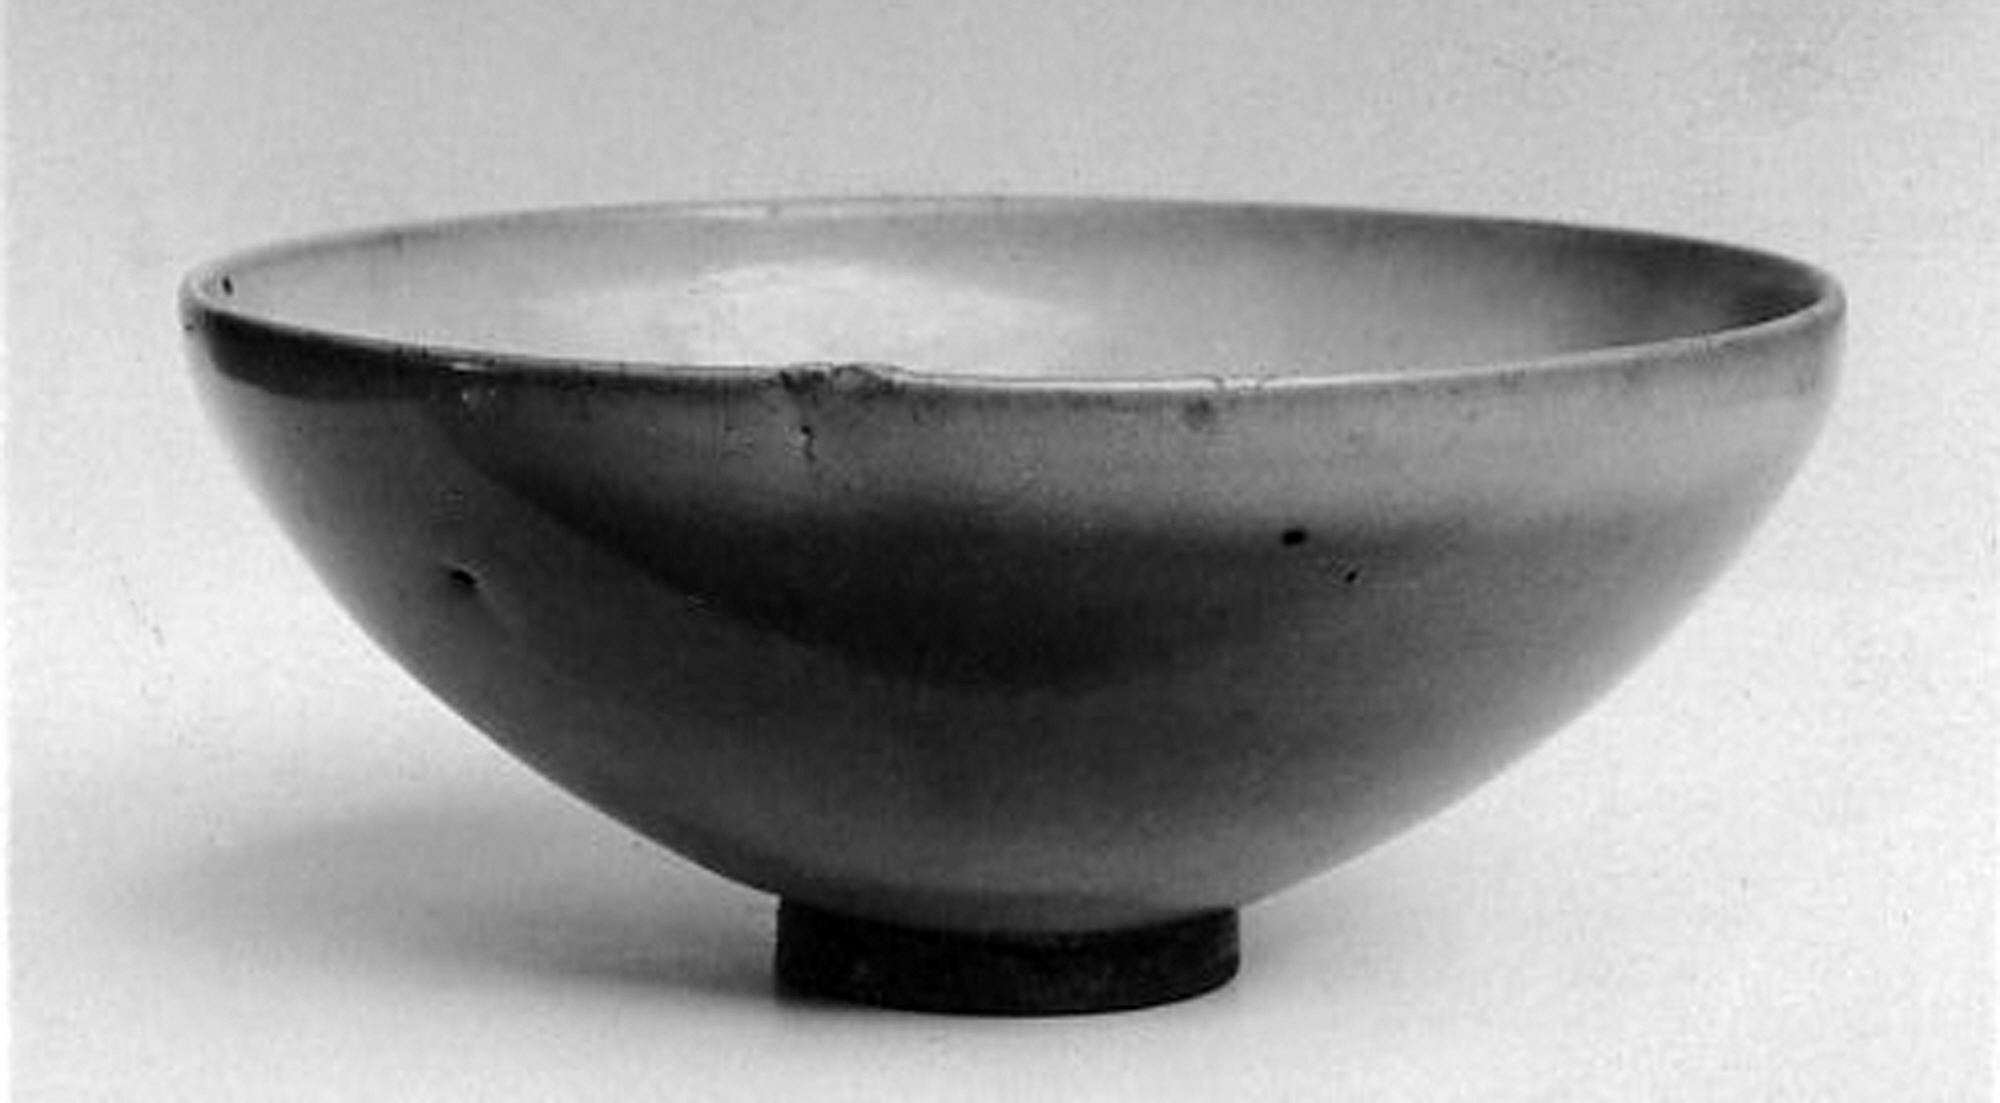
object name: bowl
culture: chinese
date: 1001-1200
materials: glaze, stoneware